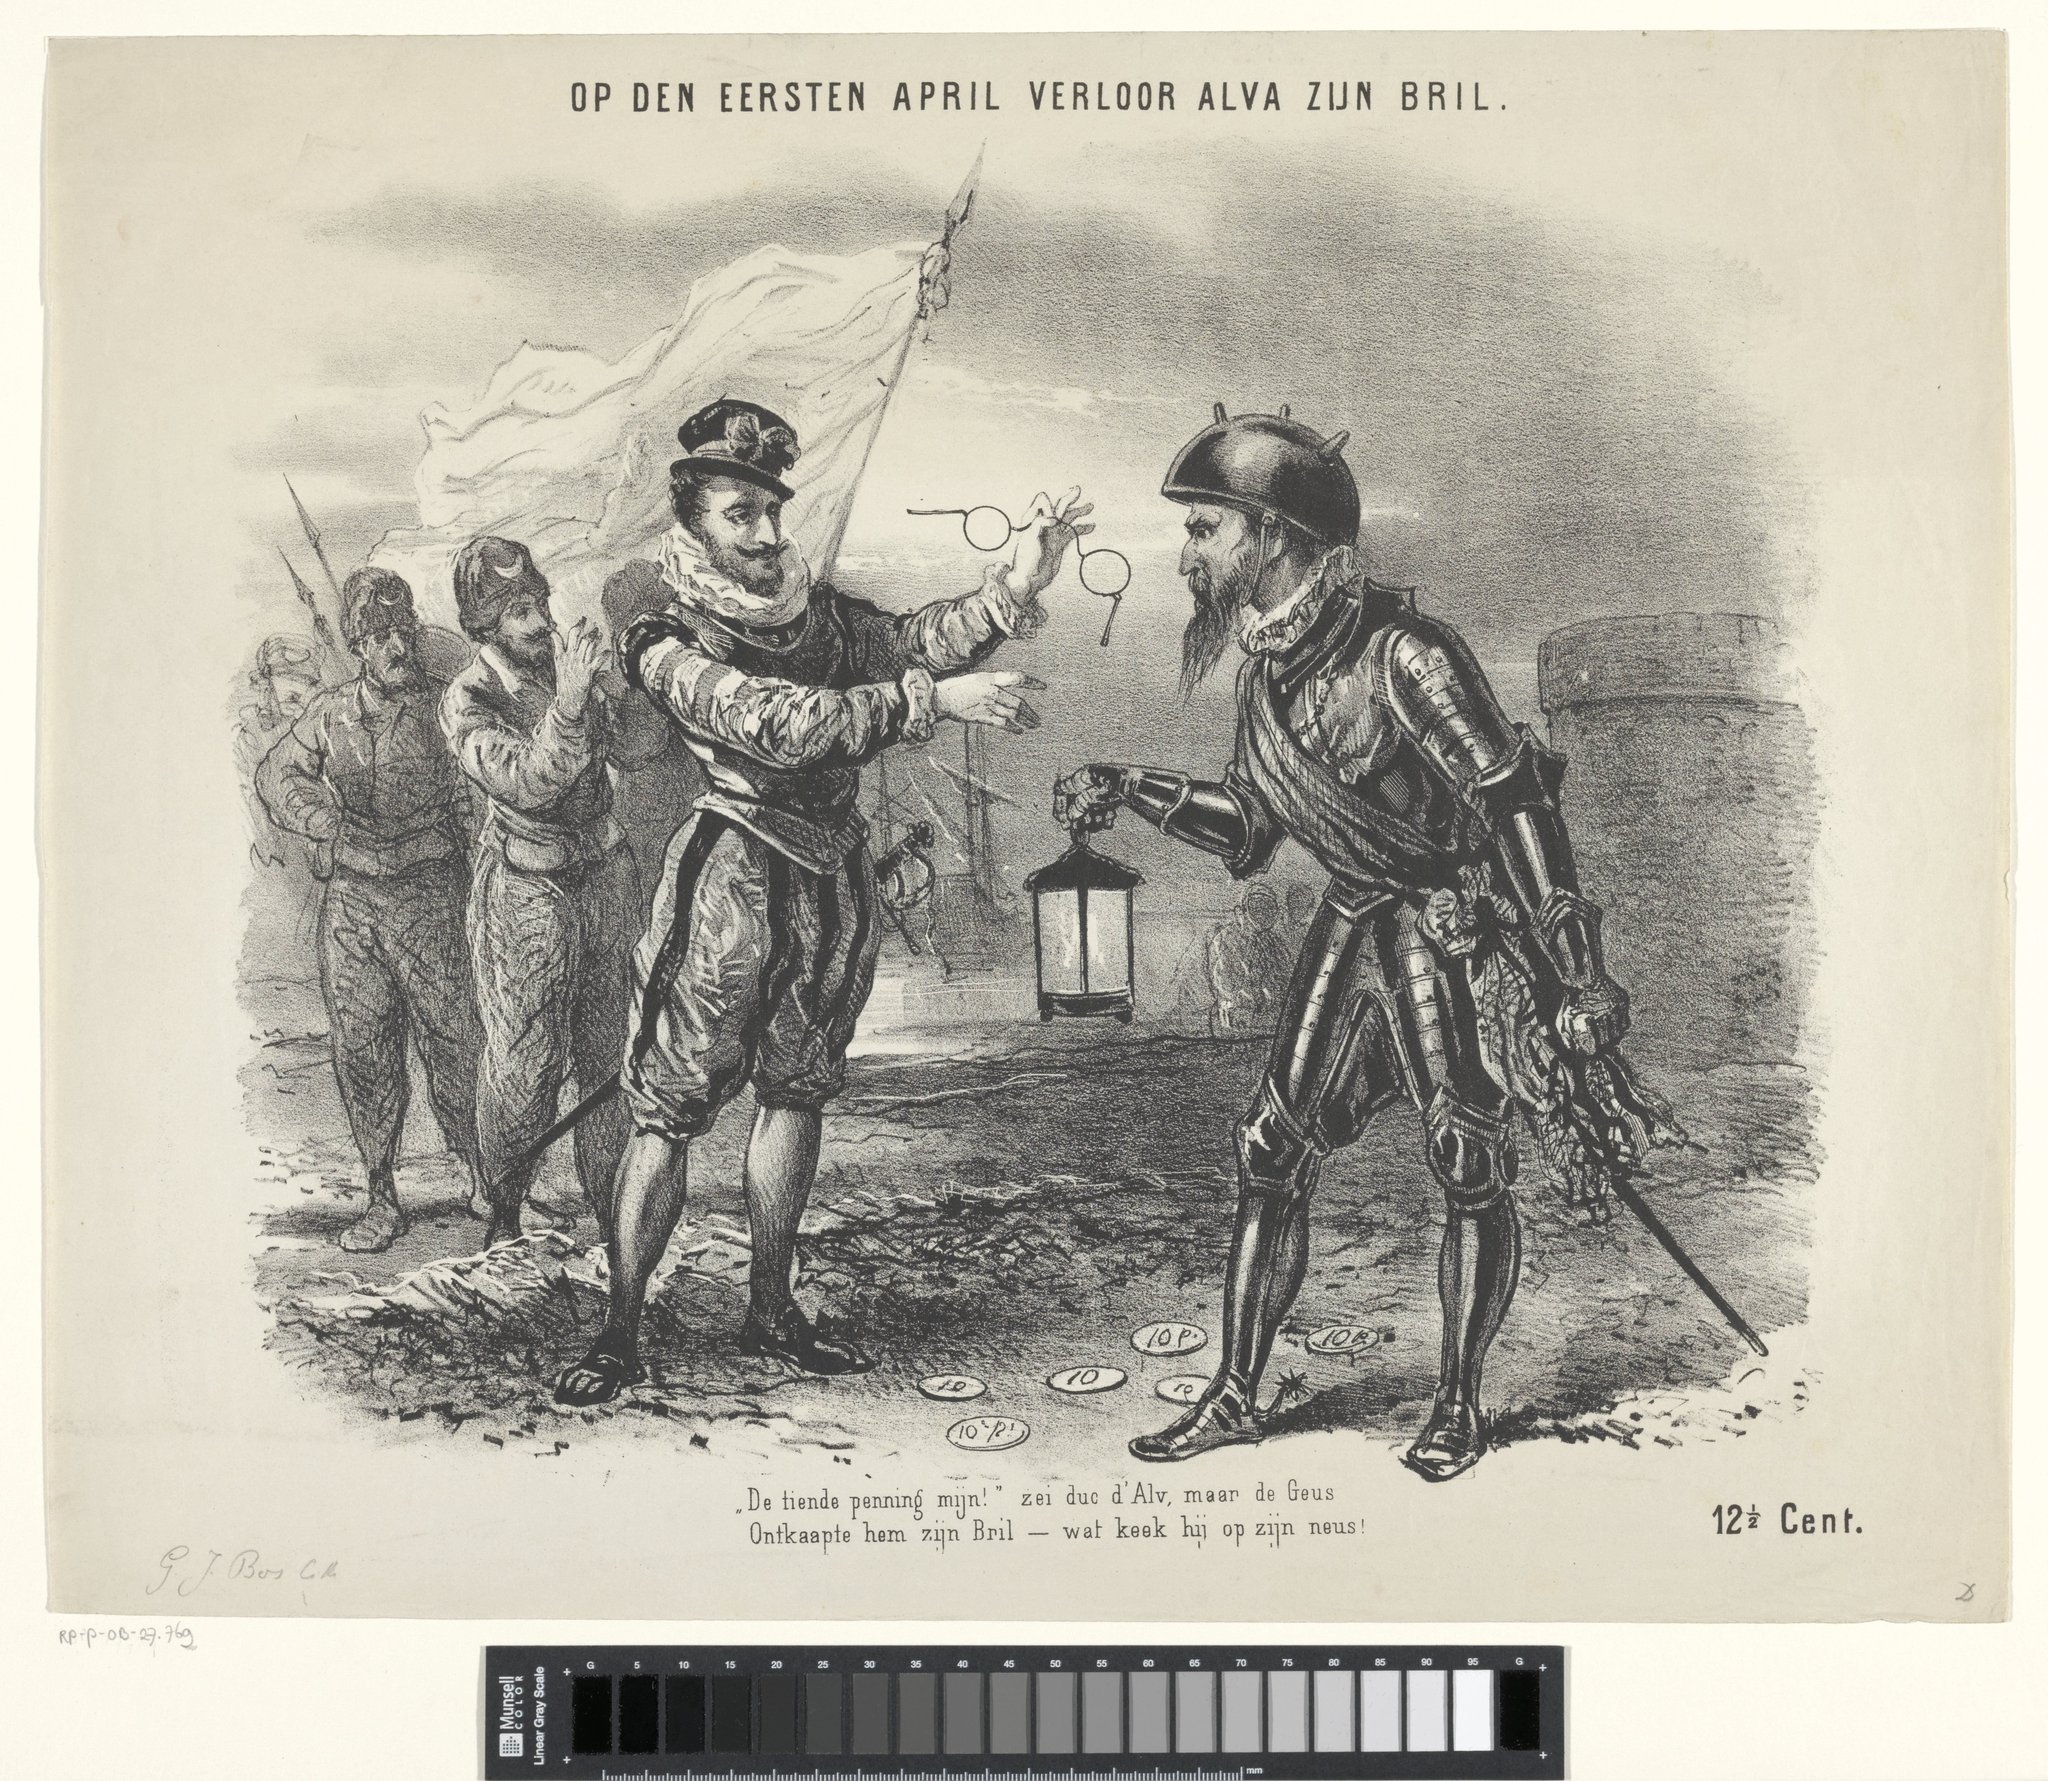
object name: print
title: Op den eersten april verloor Alva zijn bril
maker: jan bos wz.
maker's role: print maker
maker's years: 1832-1897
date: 1842-1897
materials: paper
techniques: lithograph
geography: netherlands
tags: fernando álvarez de toledo (3rd duke of alba), eyeglasses, spectacles, siege, brielle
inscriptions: inscription: ‘G. J. Bos Lith’, collector's mark: Lugt 2228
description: Graaf Alva loopt met een lantaarn in zijn hand. Hij draagt een harnas en helm. Op de grond liggen munten. Hij kijkt op naar een Geus die voor hem staat met zijn bril in zijn hand.